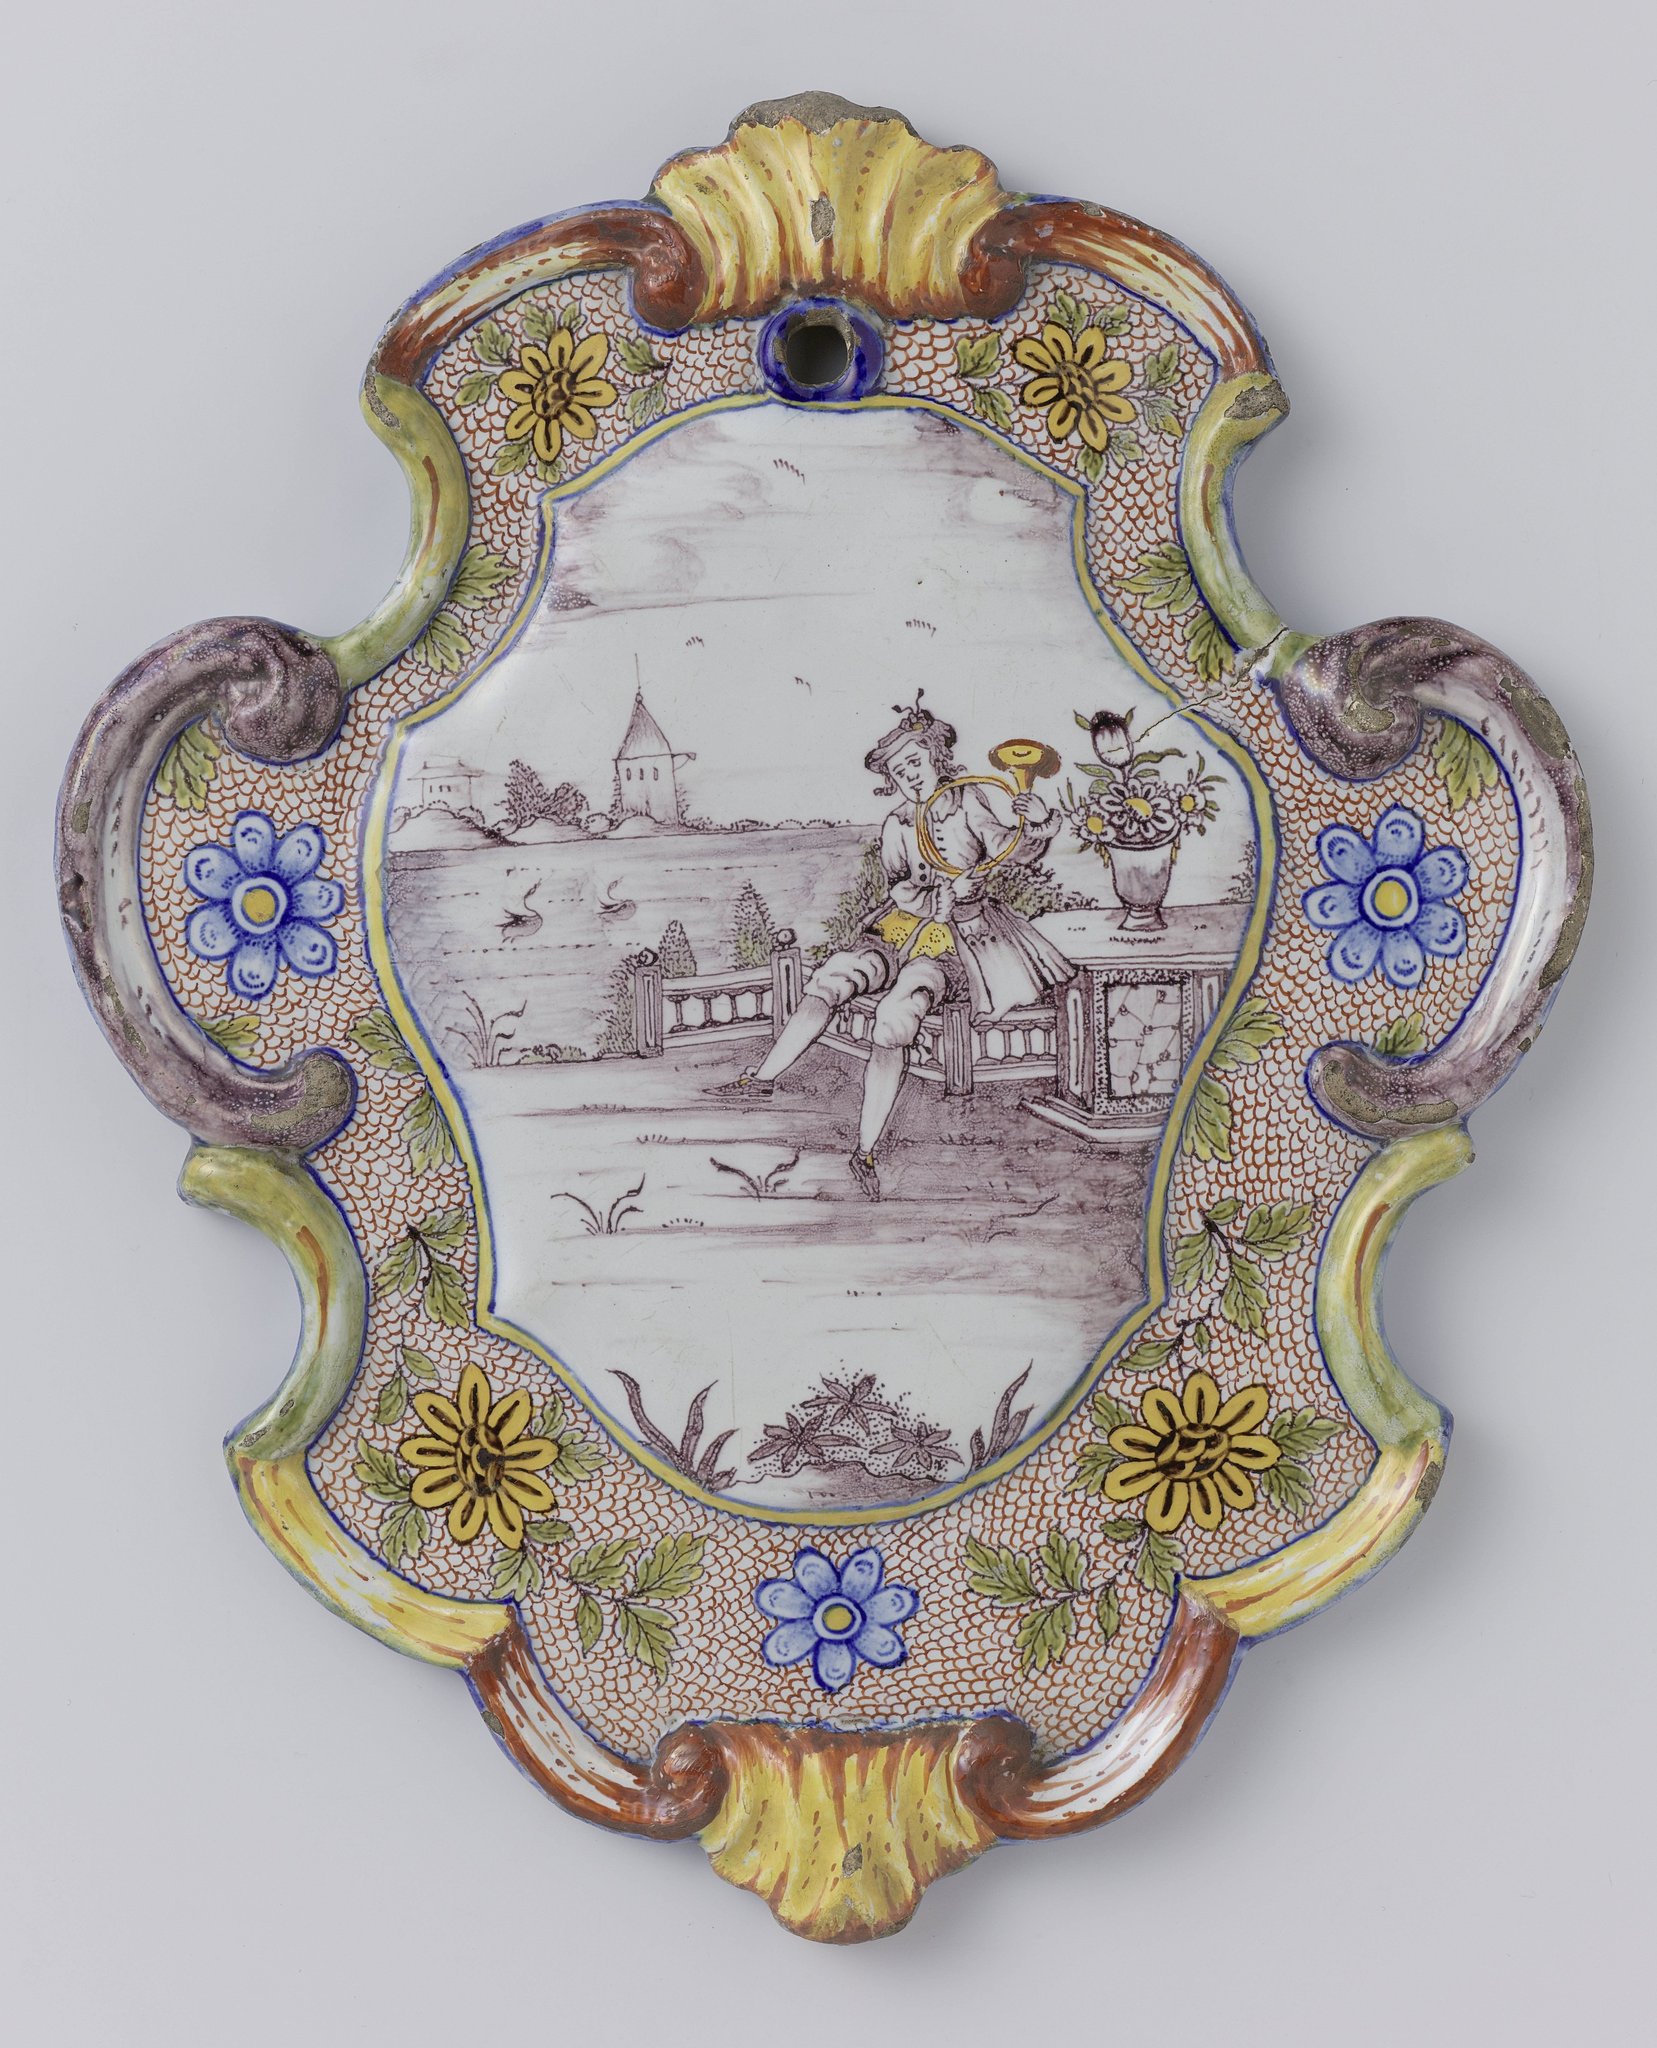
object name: plate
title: Plaat, cartouchevormig, veelkleurig beschilderd met een hoornblazende man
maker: Anonymous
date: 1740-1780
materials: faience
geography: delft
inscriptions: collector's mark: ‘collection J.F. Loudon’, inscription: ‘A'dam RM 4’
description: Plaat van faïence, cartouchevormig. Veelkleurig beschilderd met een hoornblazende man.